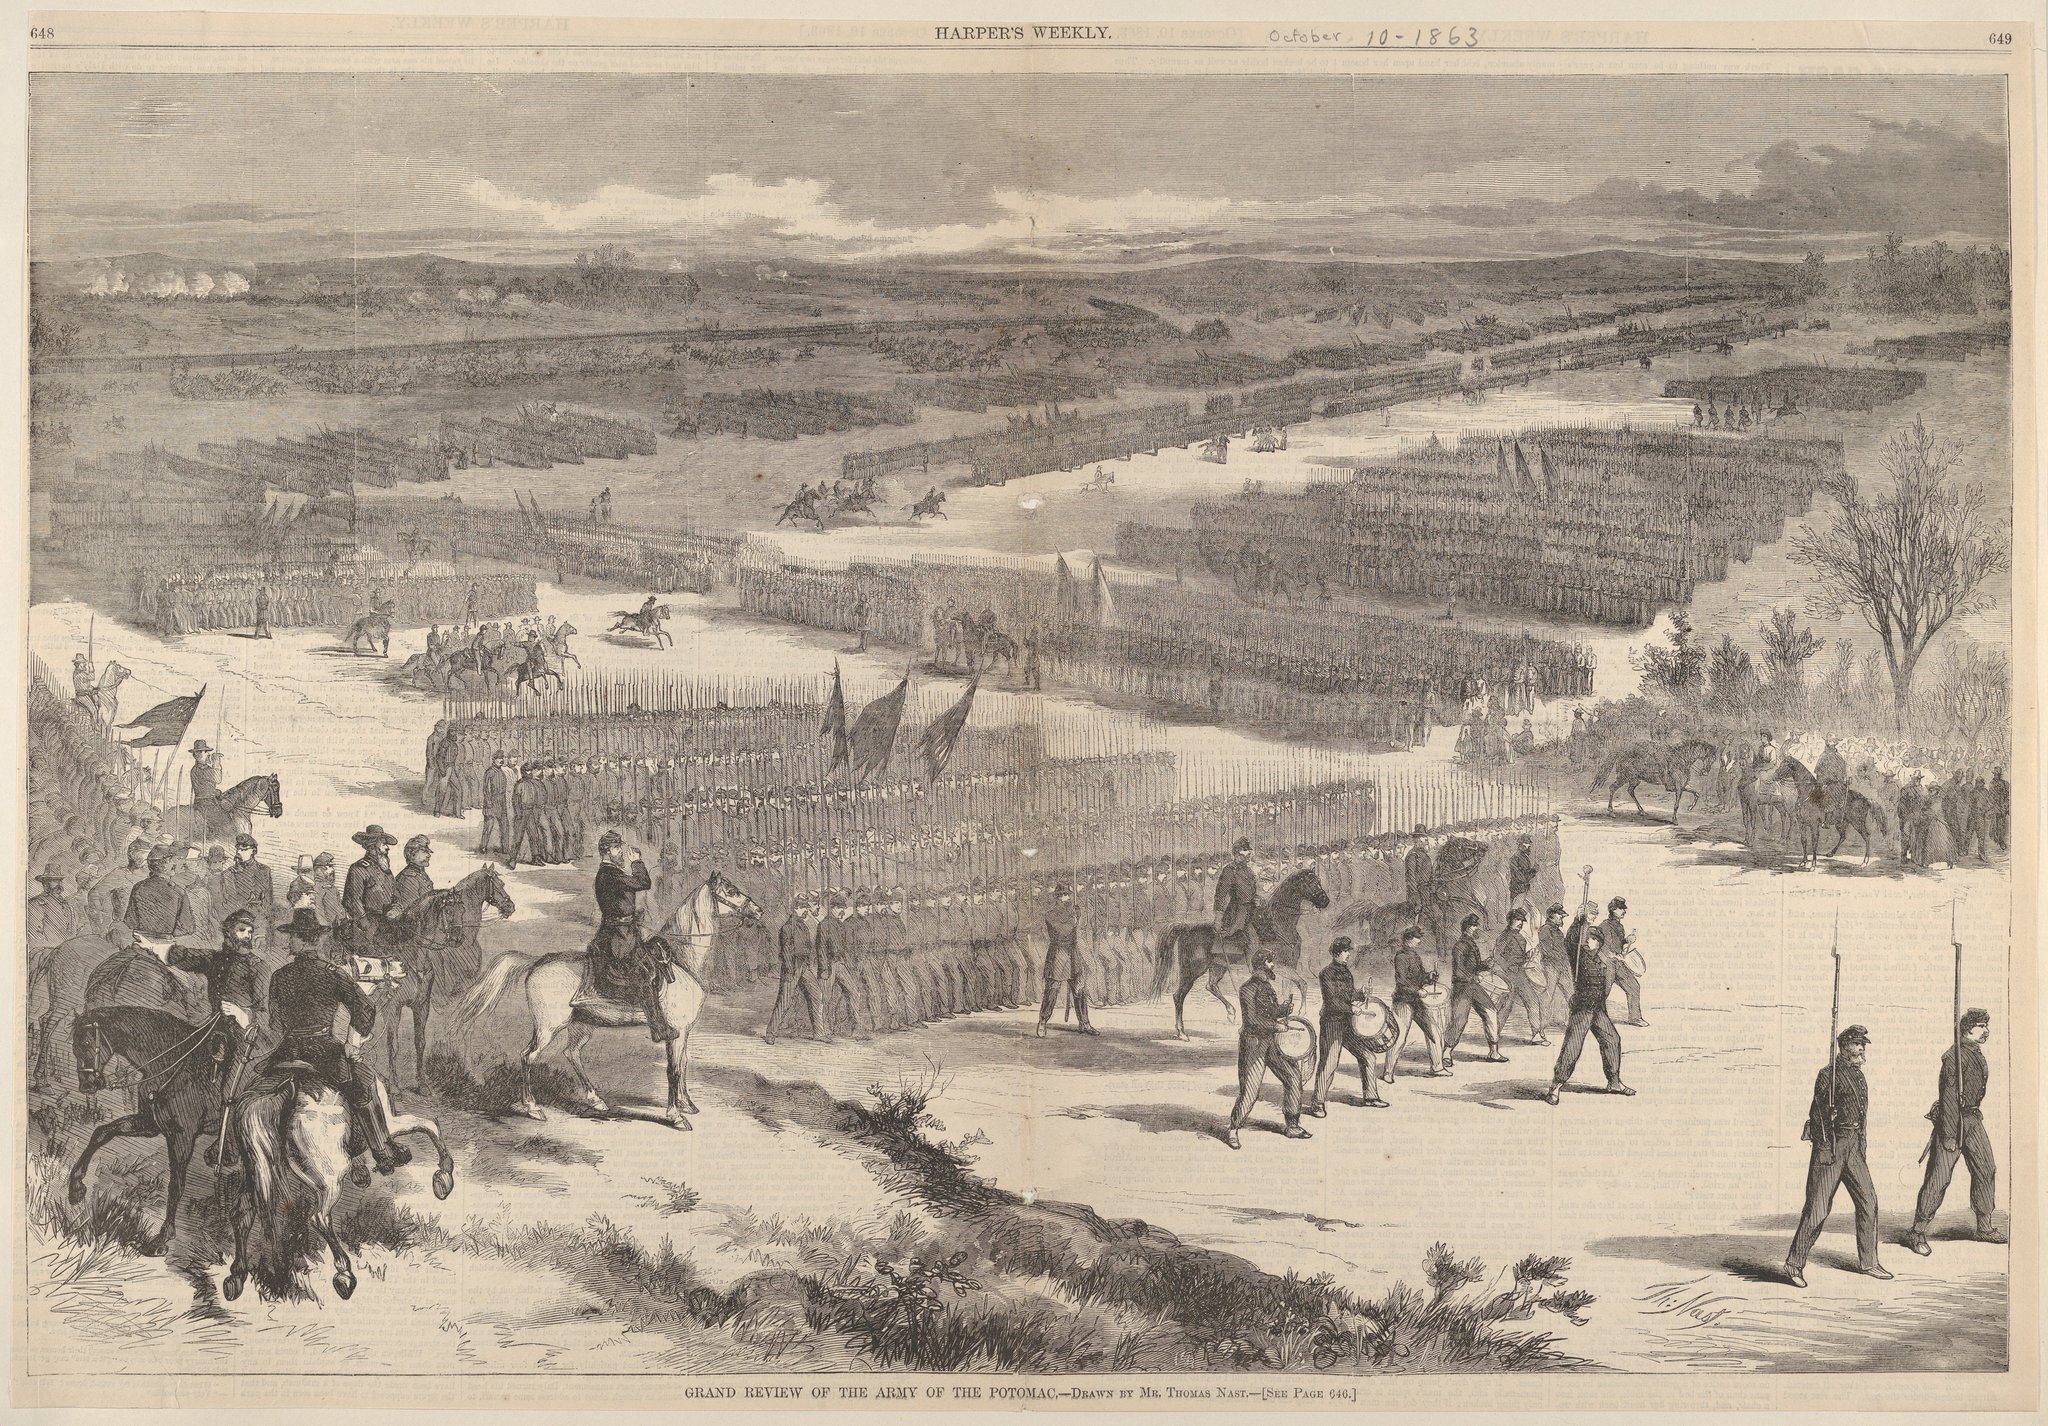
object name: print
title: Grand Review of the Army of the Potomac – Drawn by Mr. Thomas Nast (from "Harper's Weekly")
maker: thomas nast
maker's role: artist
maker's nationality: american, born germany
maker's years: 1840-1902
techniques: engraving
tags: army,soldiers,american civil war,men,horses